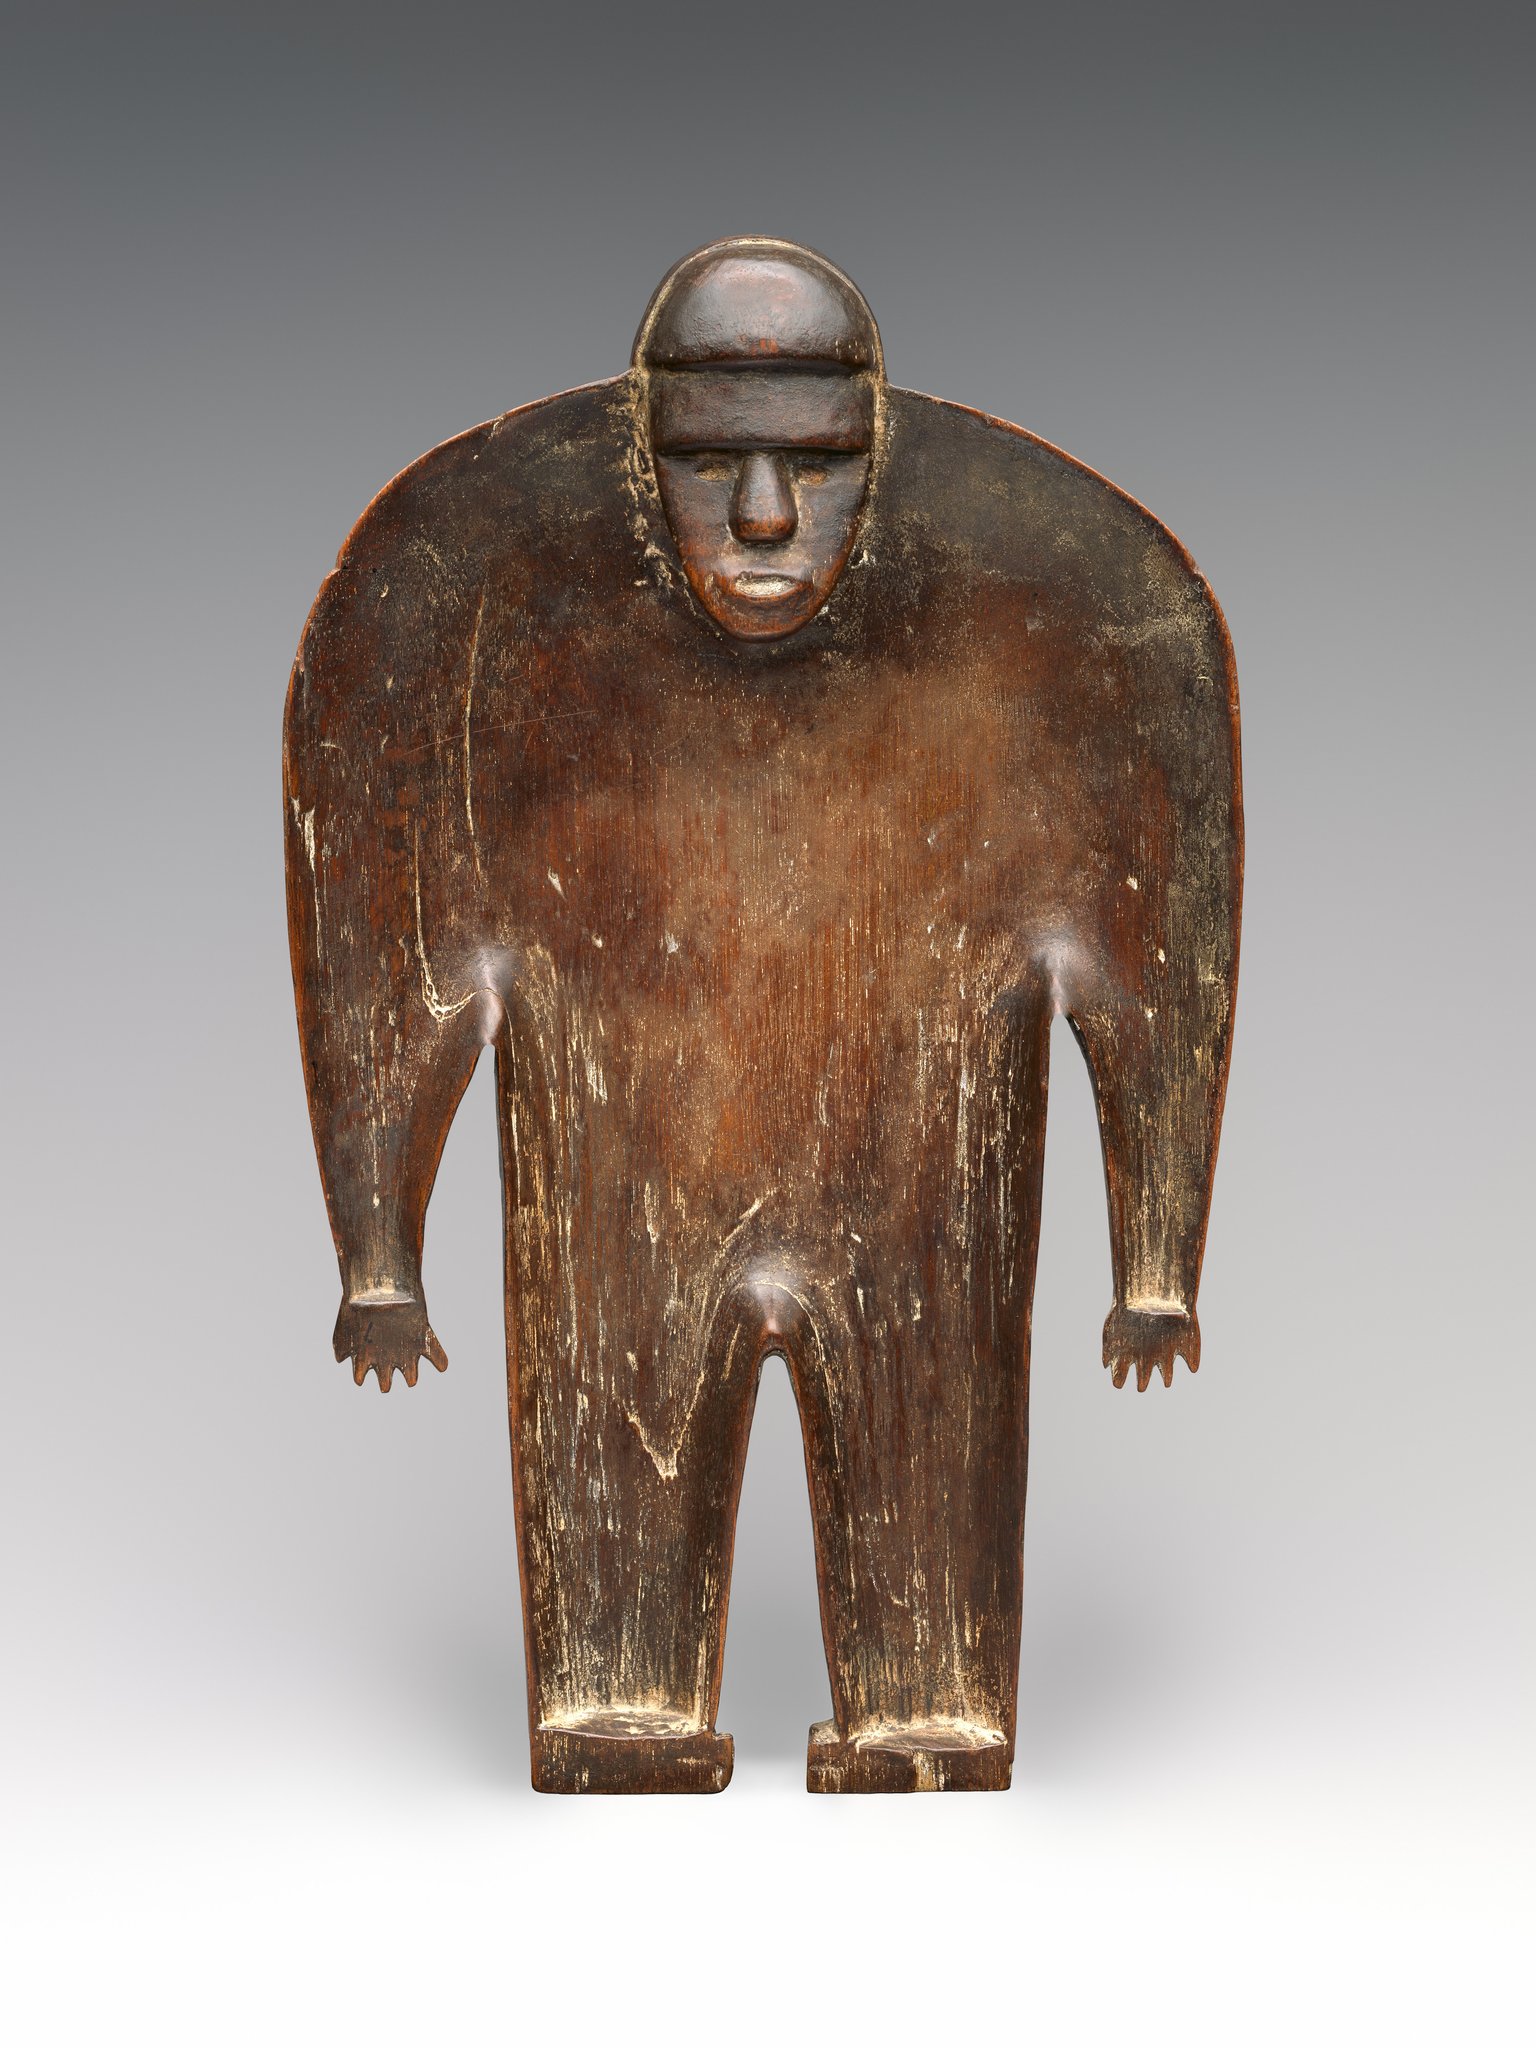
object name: dish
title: Ritual dish (daveniyaqona)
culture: fijian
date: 1801-1833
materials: wood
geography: fiji